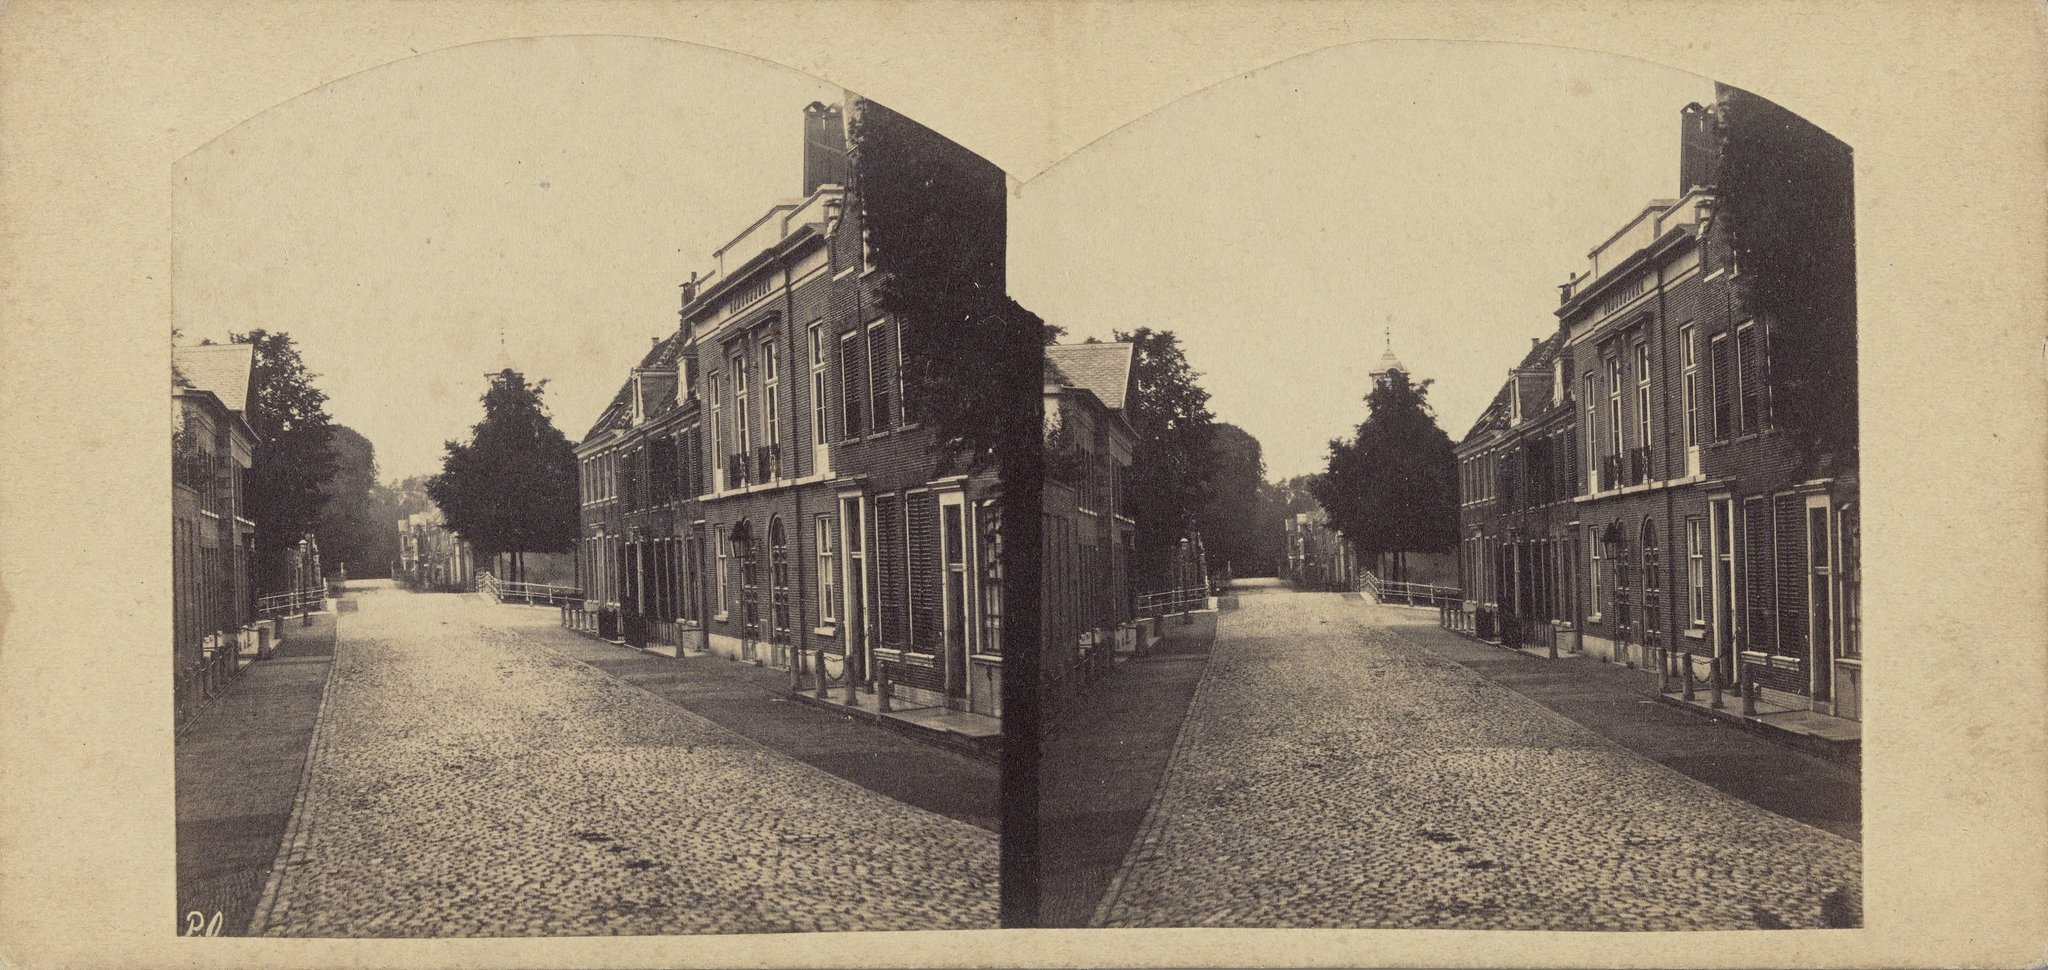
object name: stereograph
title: Gezicht op de Jansweg te Haarlem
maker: pieter oosterhuis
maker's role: draughtsman, print maker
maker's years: 1816-1885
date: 1860-1870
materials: cardboard, paper, photographic support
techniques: albumen print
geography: haarlem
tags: street (+ city(-scape) with figures, staffage), haarlem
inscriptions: inscription: ‘Haarlem’, inscription: ‘PO’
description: Gezicht op de Jansweg te Haarlem. Rechts de Schouwburg en verderop, over de brug achter de boom, het torentje van het Hofje van Staats.